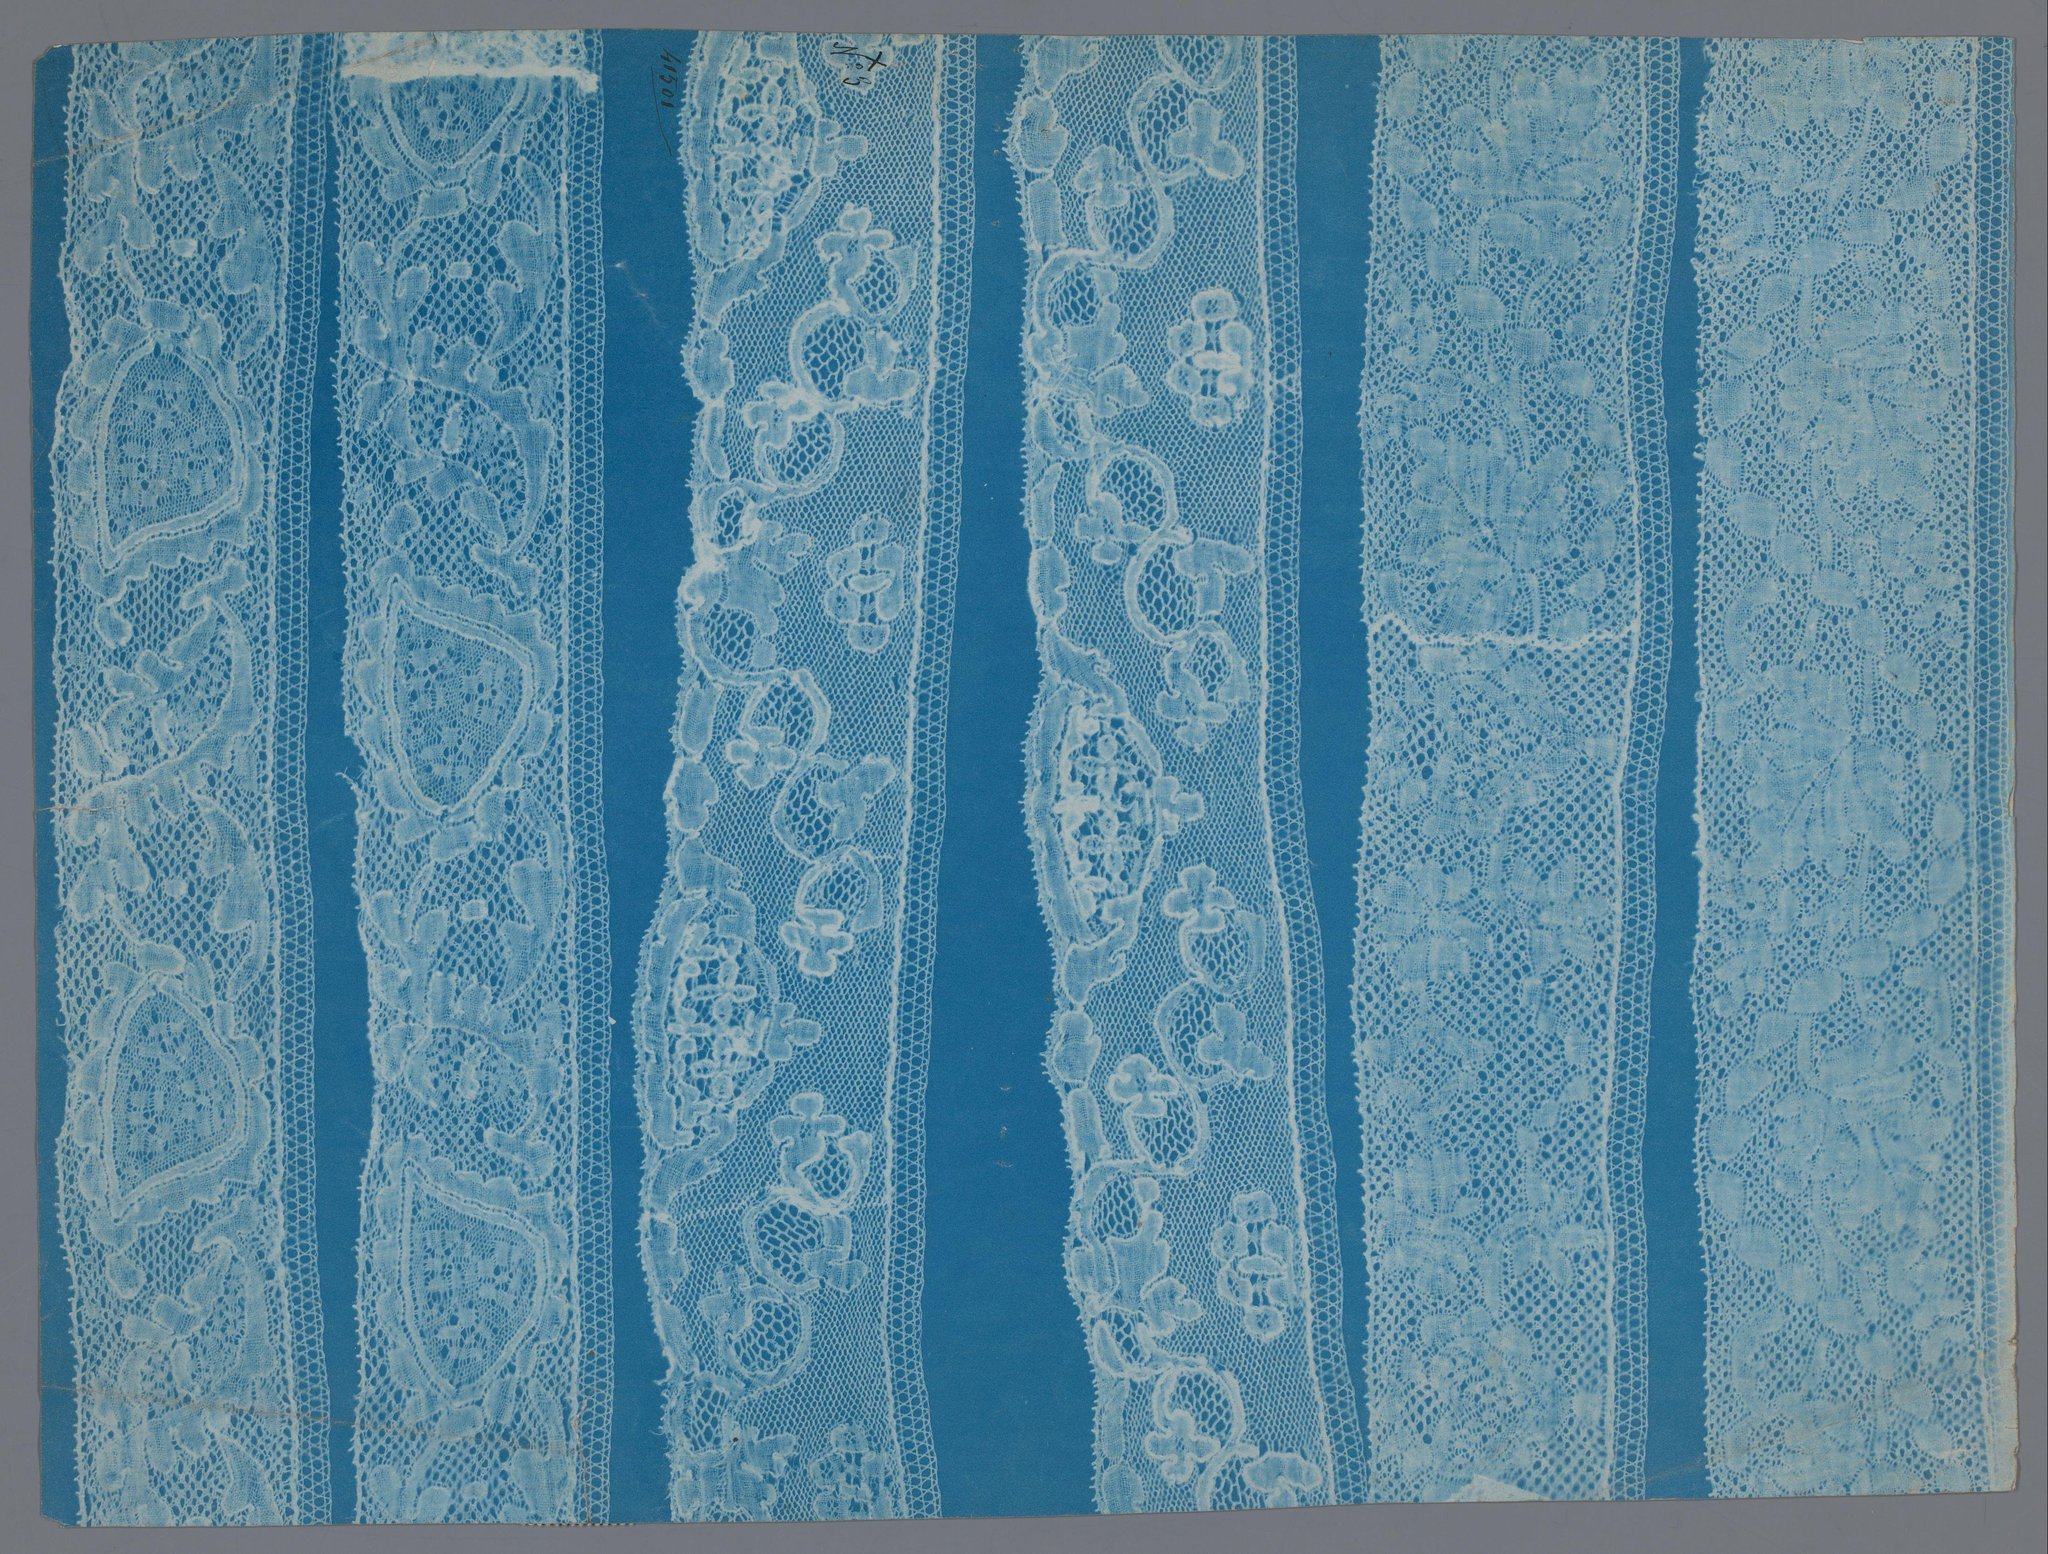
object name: photogram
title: Voorbeeld van kant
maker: Anonymous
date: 1890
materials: paper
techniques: cyanotype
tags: lace